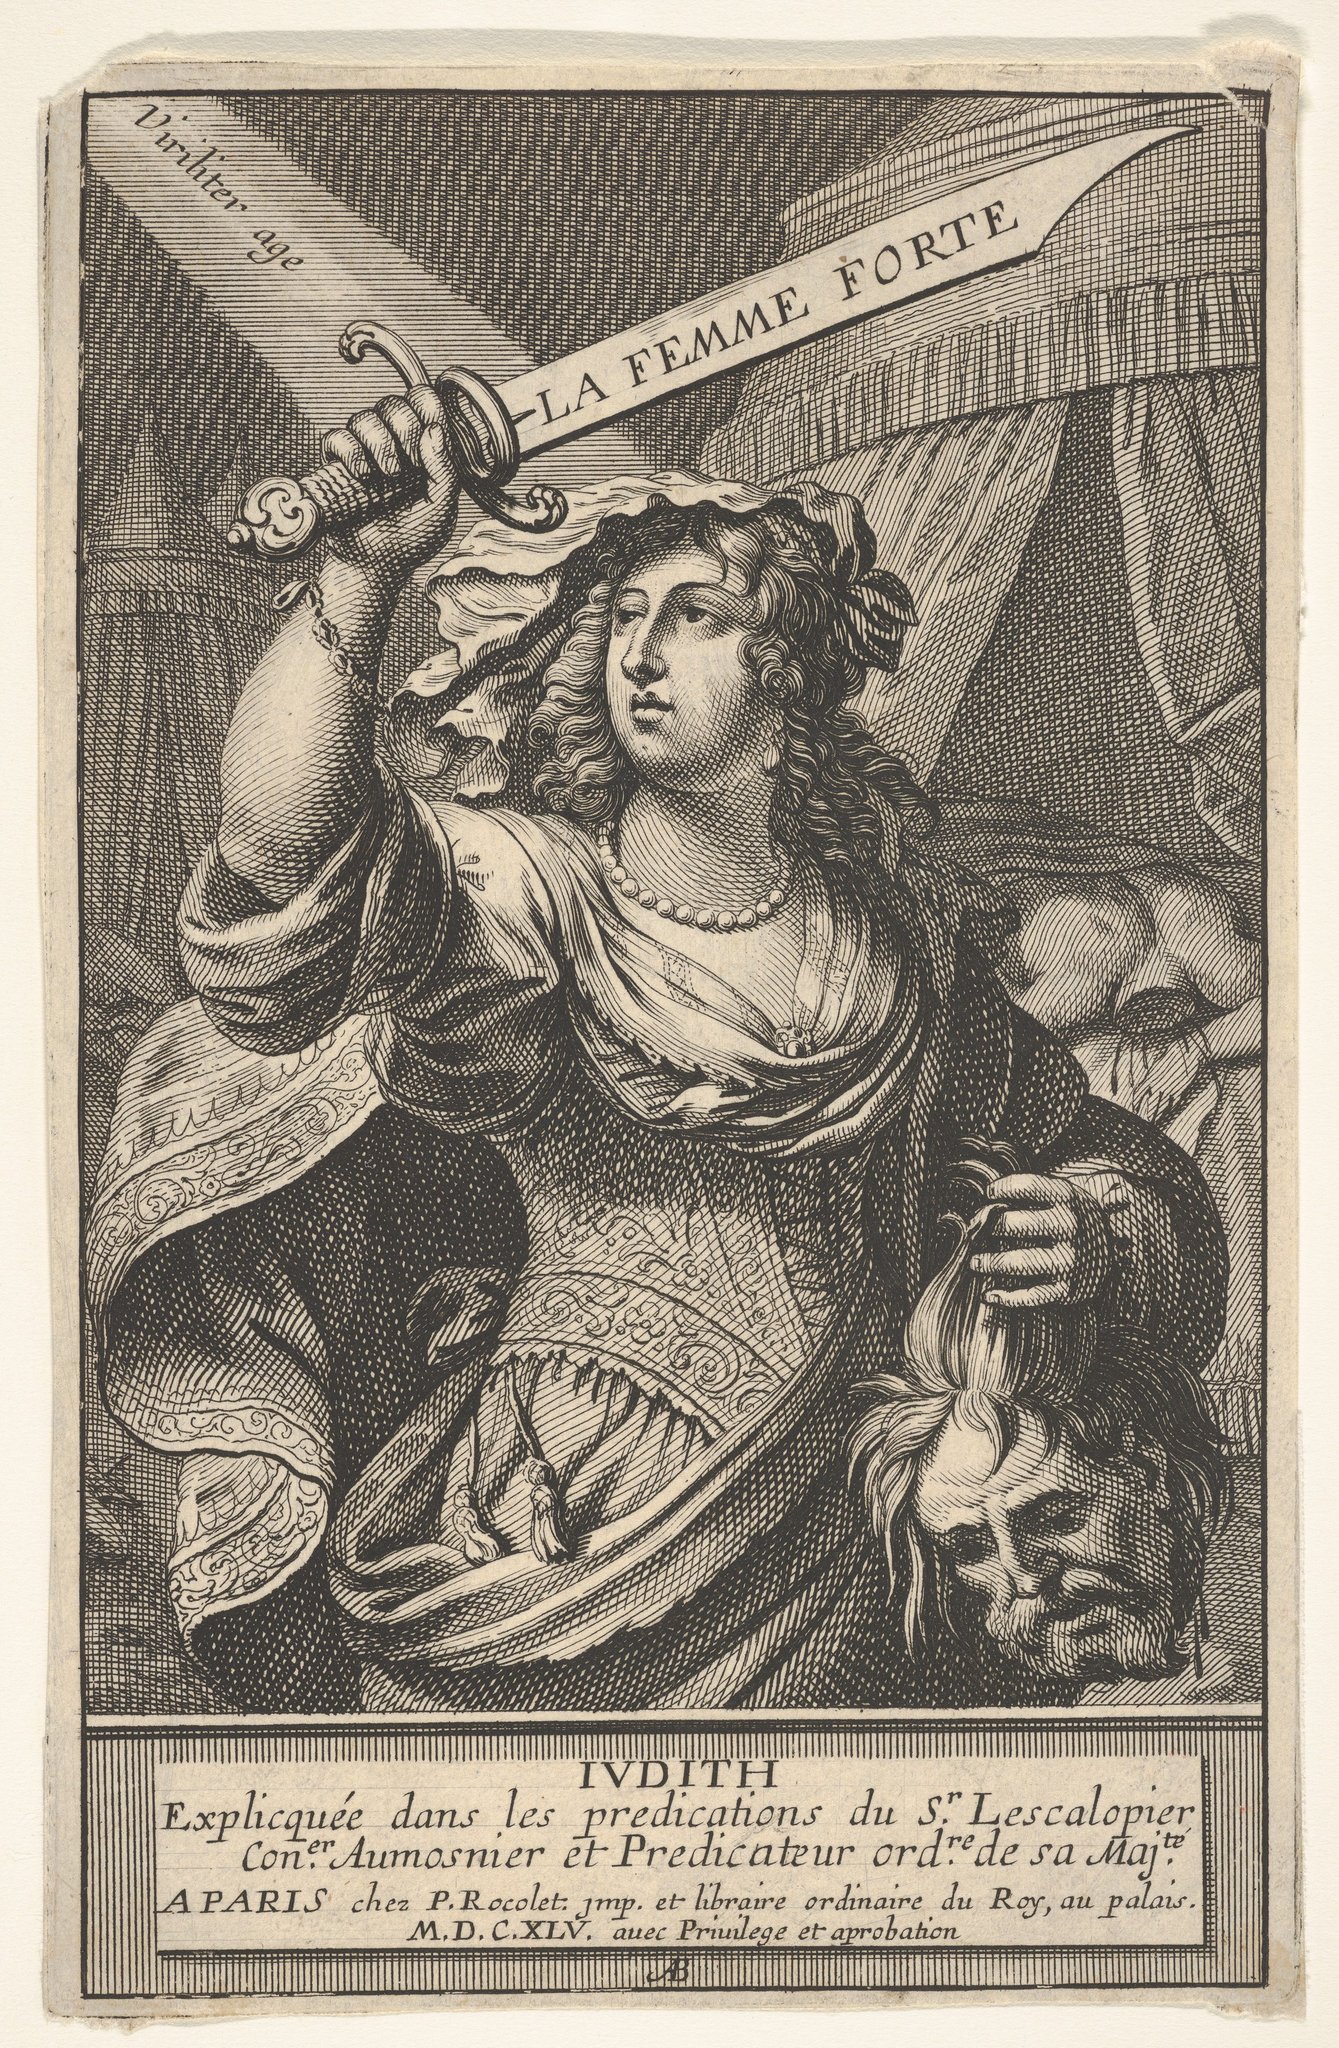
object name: print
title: Judith and Holofernes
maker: abraham bosse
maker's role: artist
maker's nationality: french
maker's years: 1602-1676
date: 1645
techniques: engraving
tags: swords,heads,holofernes,judith